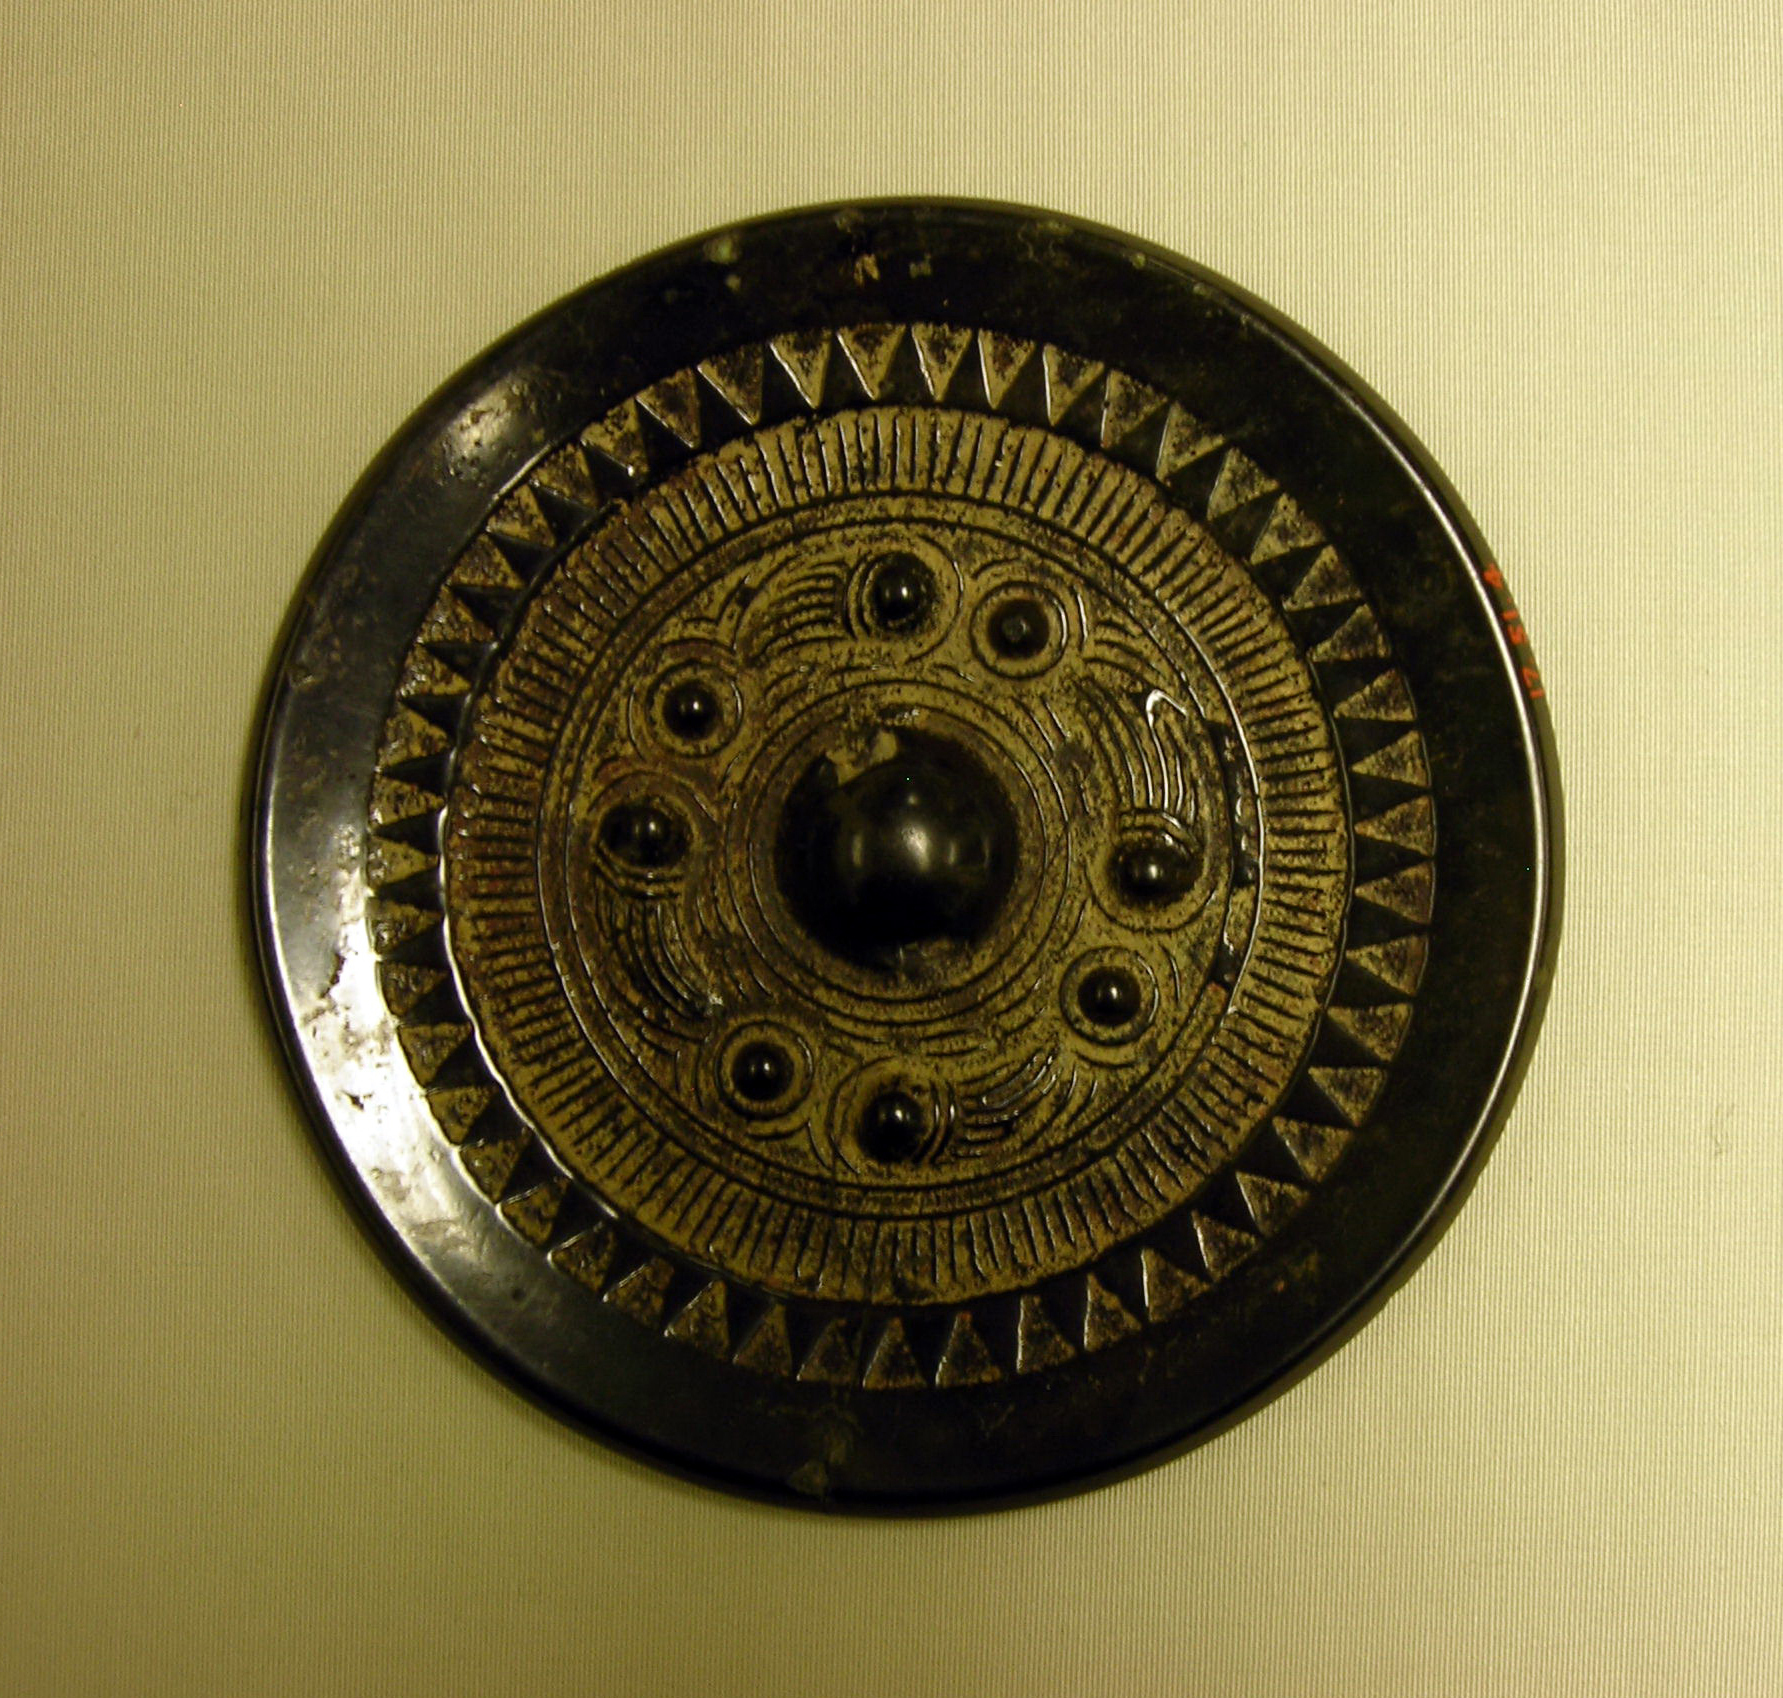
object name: mirror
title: Mirror with knobs and swirls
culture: chinese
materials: bronze, patina